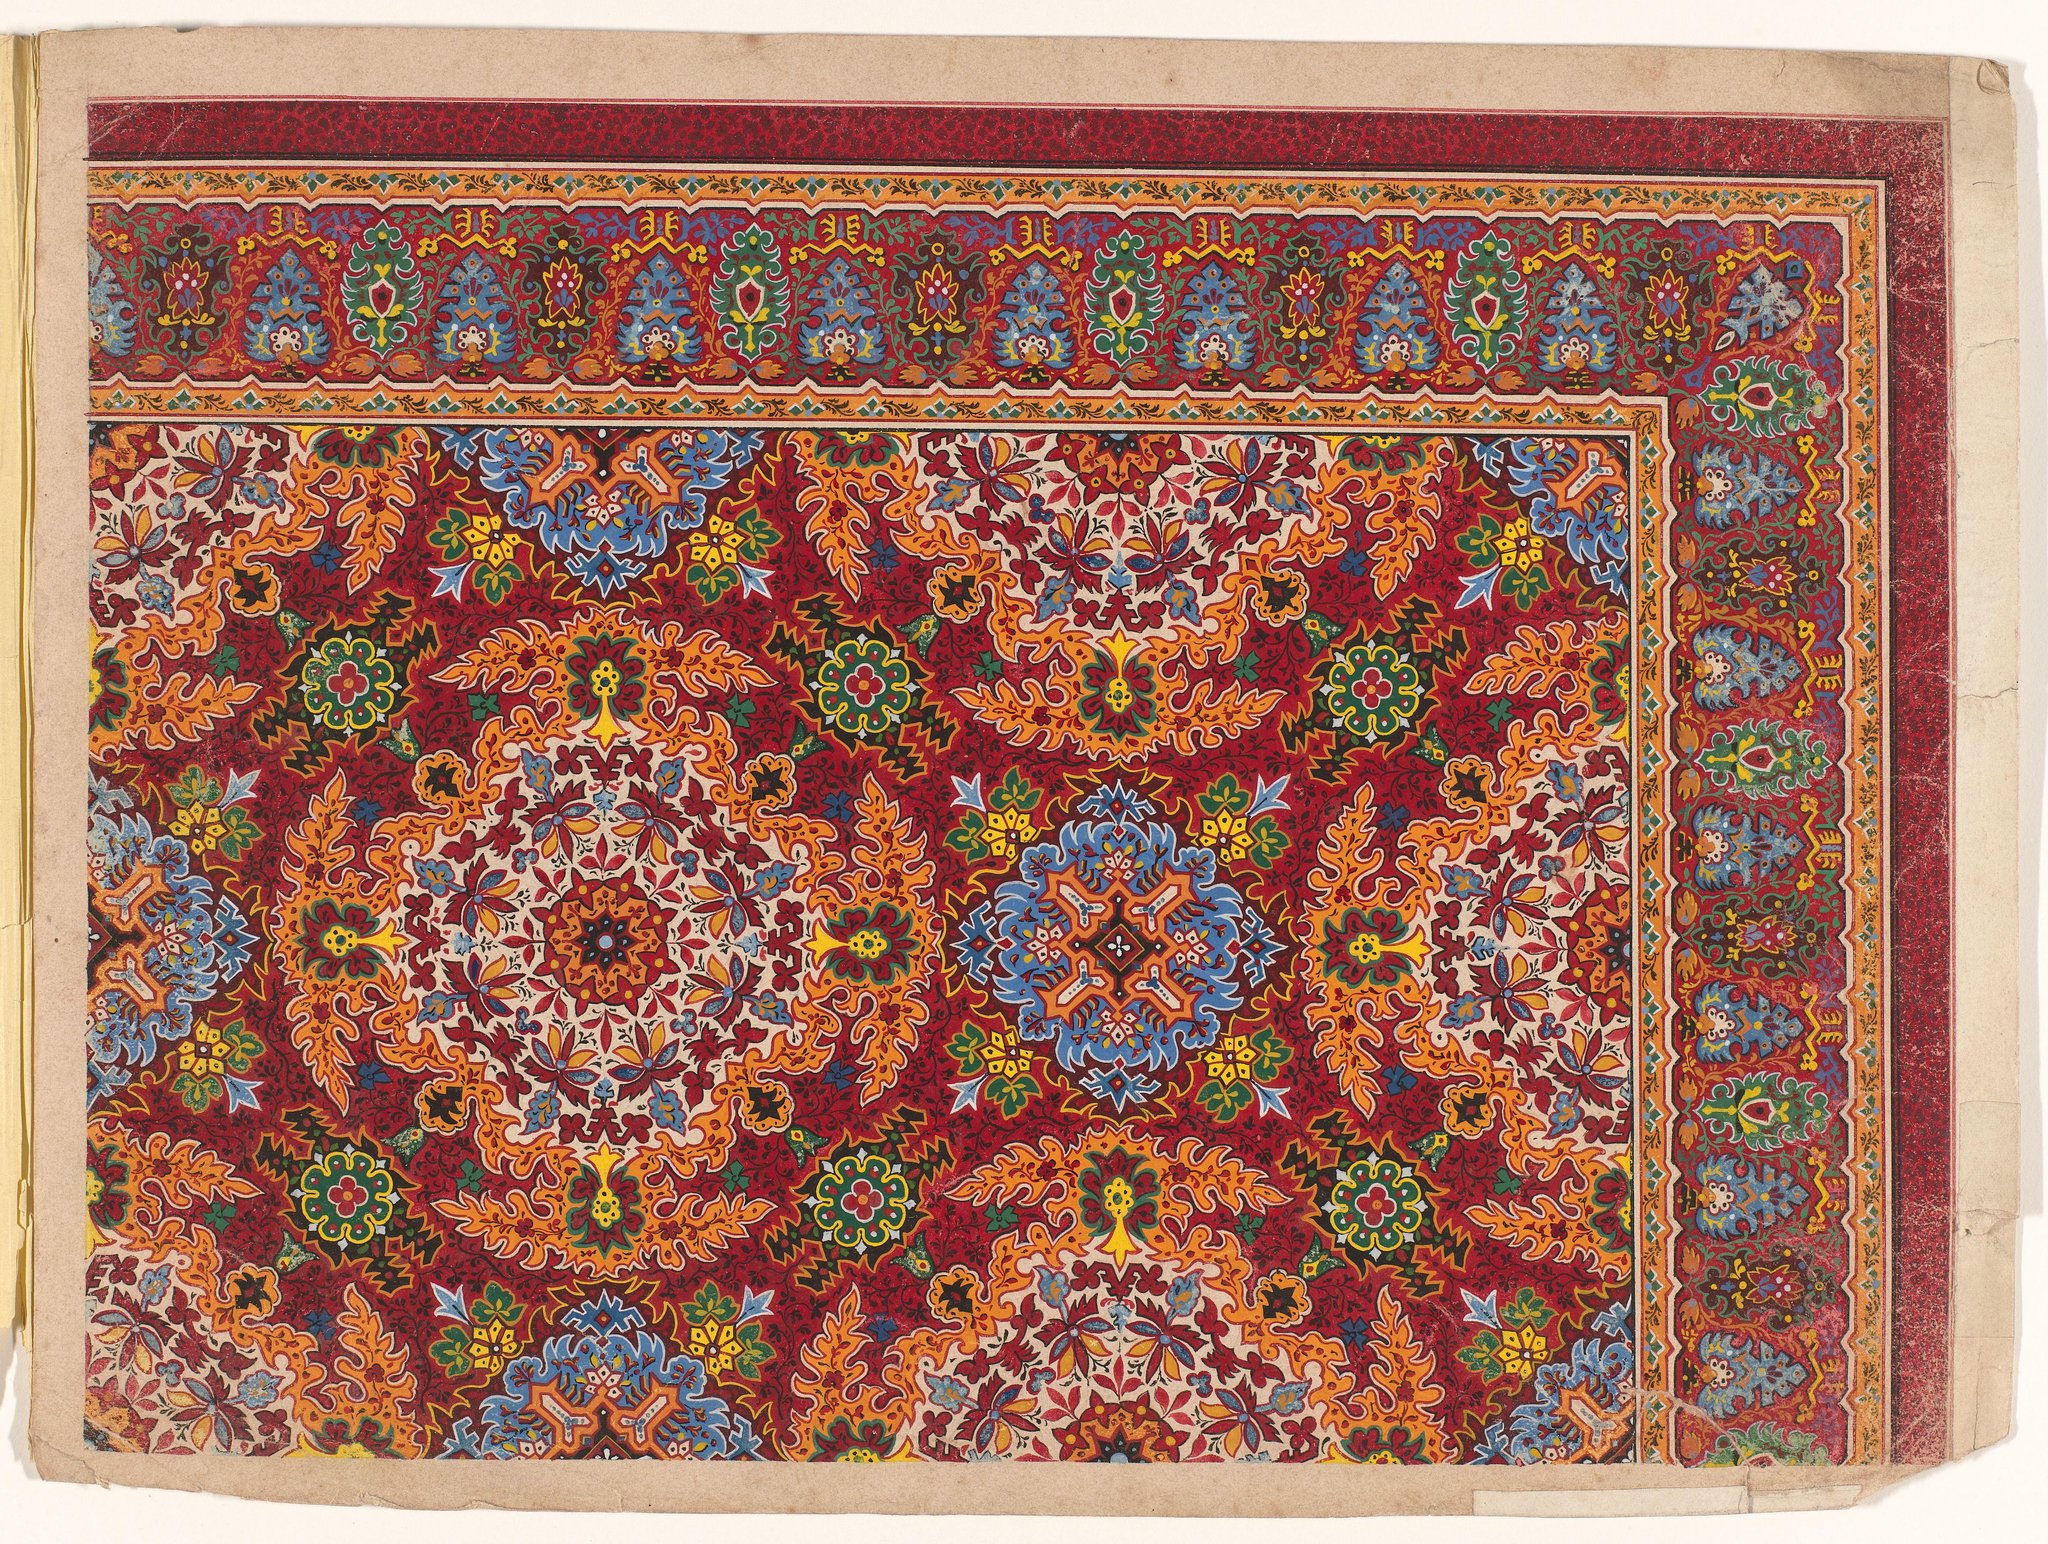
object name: drawing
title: Ontwerp voor een tapijt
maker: Anonymous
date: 1854-1864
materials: gouache, paper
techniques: brush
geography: deventer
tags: ornaments ~ art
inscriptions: inscription: ‘cf. C. 2’, inscription: ‘Y’, retailer's mark: ‘JHS.’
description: De presentatietekeningen BK-1971-77-1 t/m 86 zijn kopieën van de originele ontwerptekeningen. Ze werden gemaakt voor vertegenwoordigers van bijvoorbeeld magazijnen, die ze aan hun klanten konden tonen. De meeste tekeningen tonen een kwart van het dessin inclusief rand, middenpartij (de zogenaamde grond of fond) en centraal medaillon. Door het gebruik van spiegels kan de illusie van het gehele tapijt worden opgeroepen. Een deel van de tekeningen heeft een alfabetische opeenvolgende letter als kenmerk, de andere groep een cijfer.Waarschijnlijk is de reeks dessins met een letter eerder samengesteld dan de genummerde tekeningen.